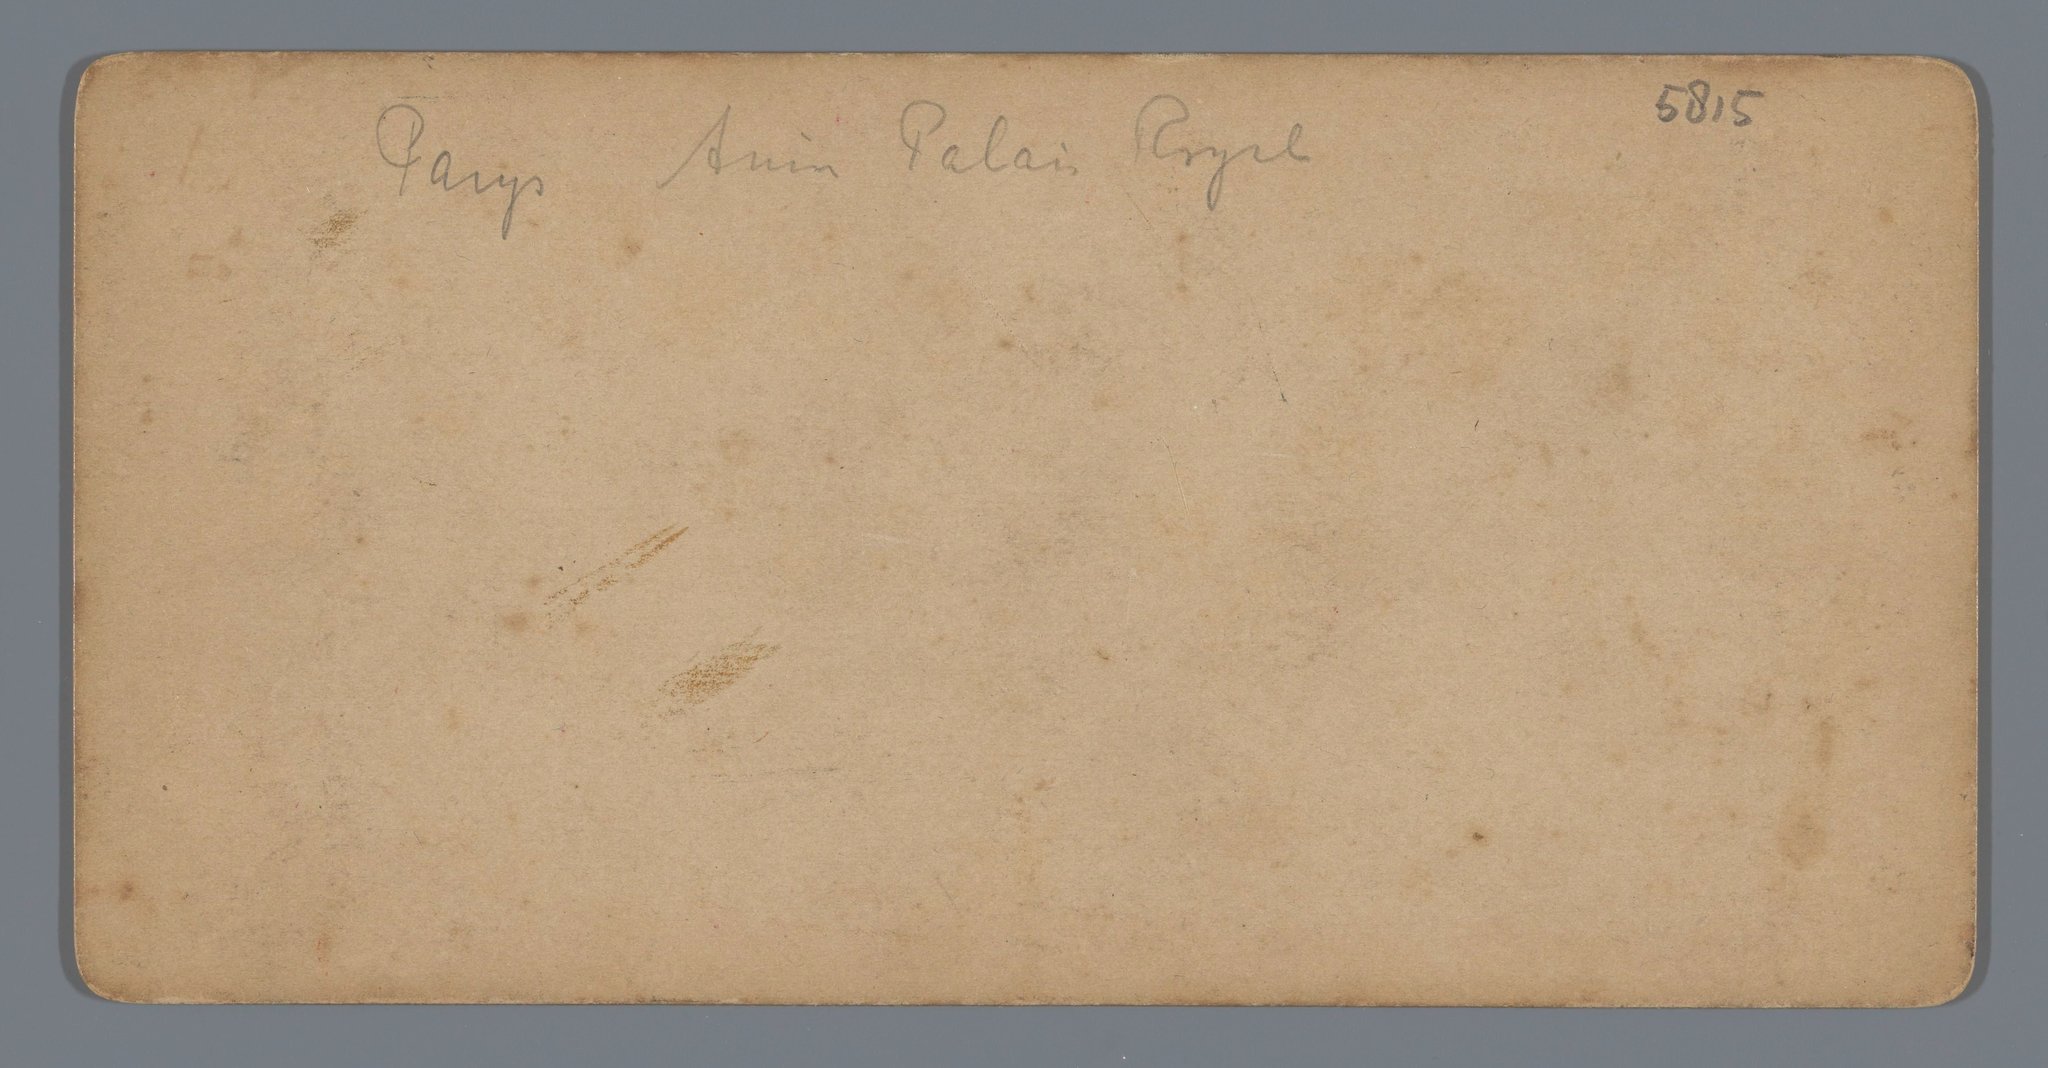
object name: stereograph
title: Gezicht op het Palais-Royal in Parijs vanuit de paleistuin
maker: Anonymous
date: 1850-1880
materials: cardboard, photographic support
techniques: albumen print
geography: paris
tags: garden, palace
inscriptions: inscription: ‘Parijs tuin Palais Royal’